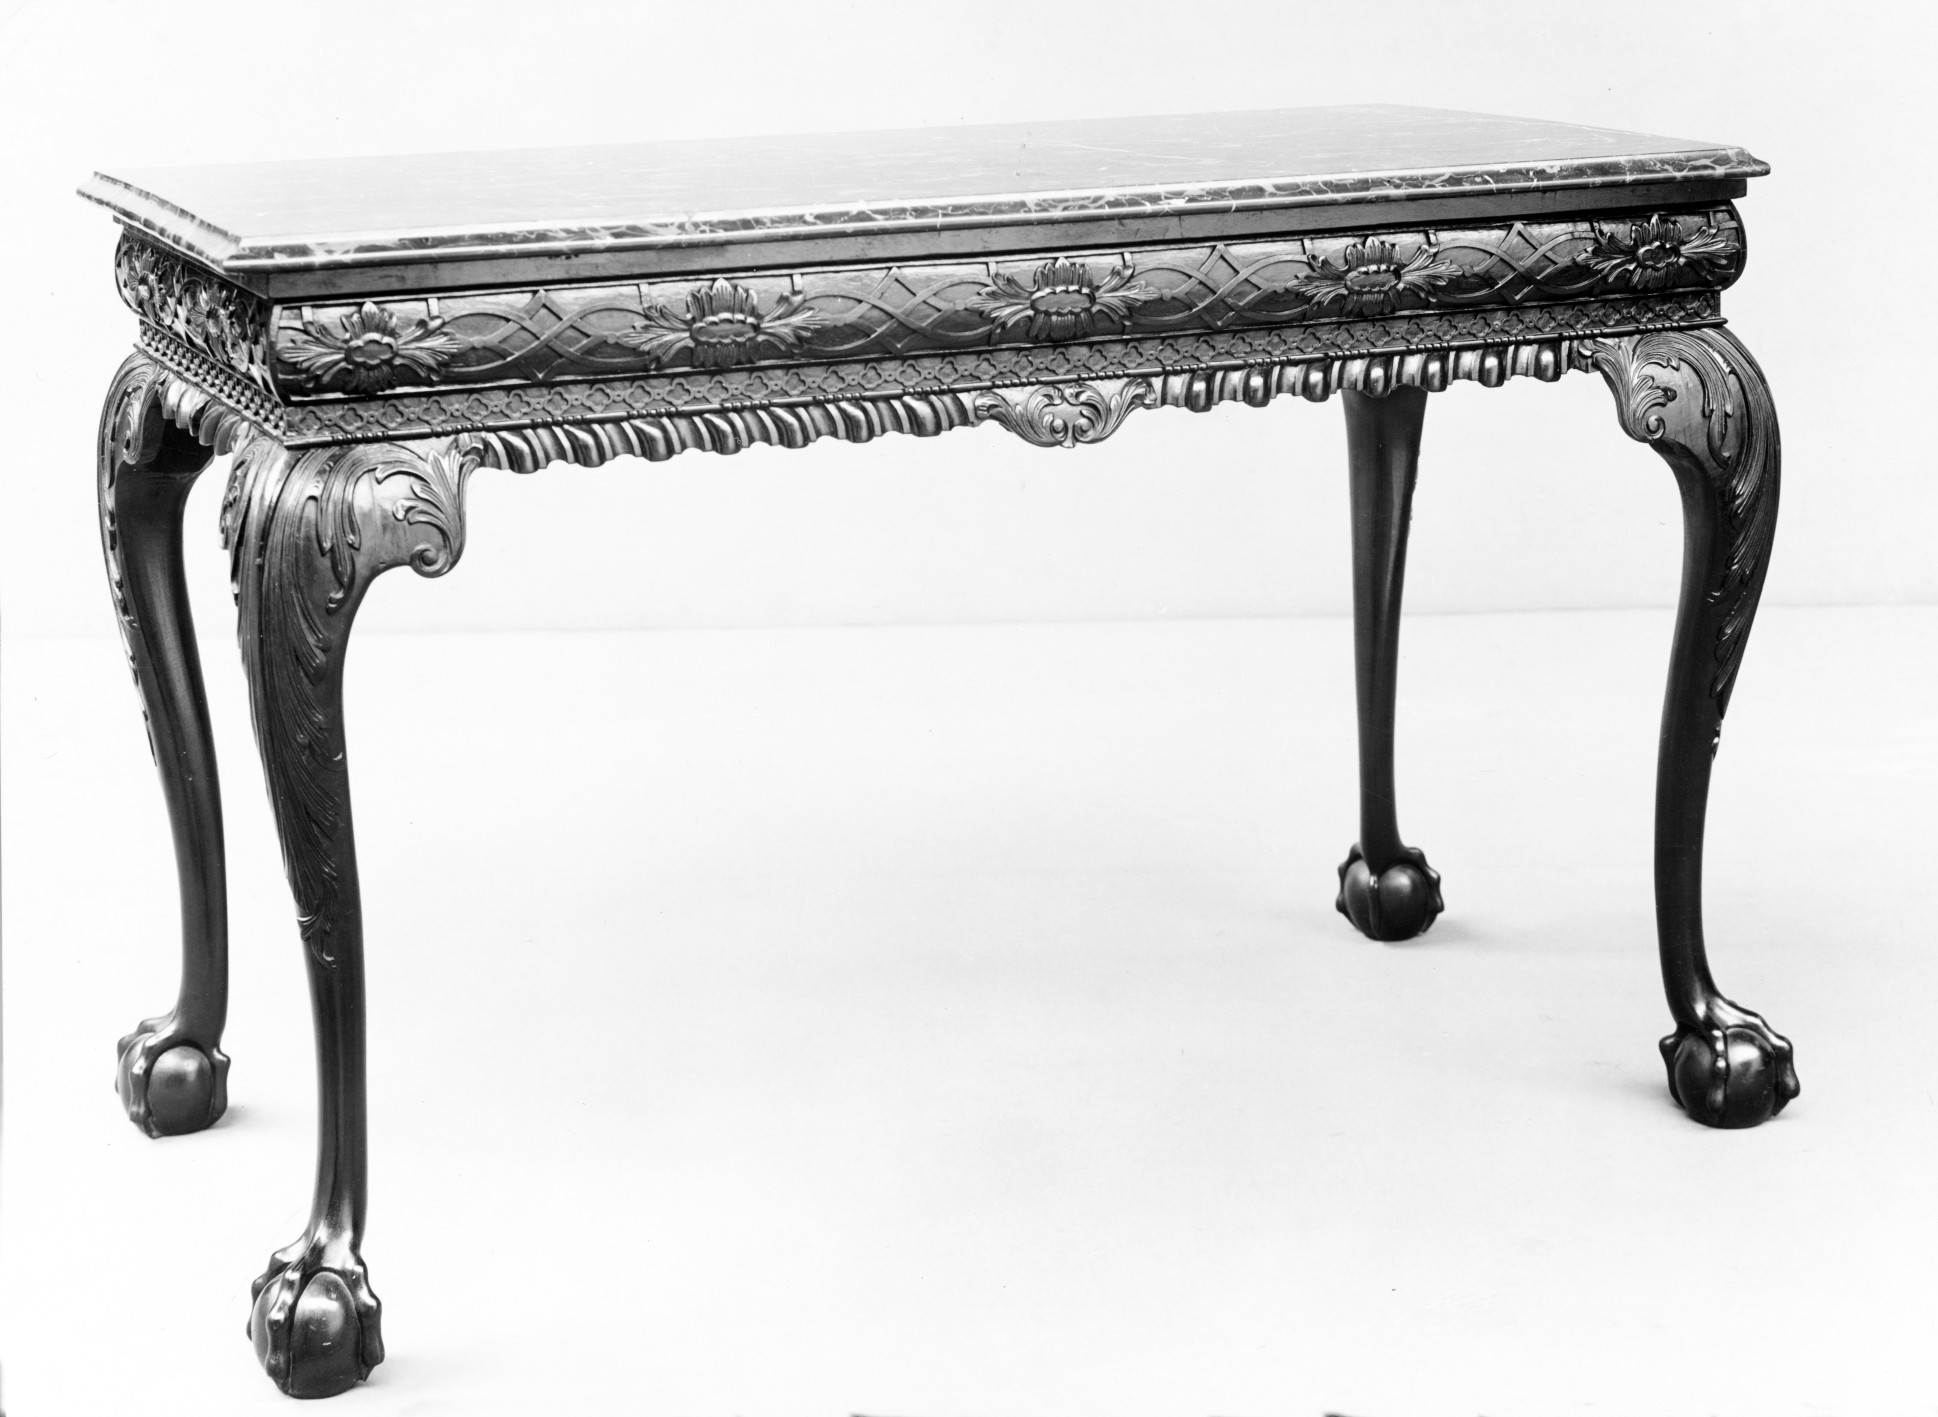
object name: pier table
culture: american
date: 1900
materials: wood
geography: united states